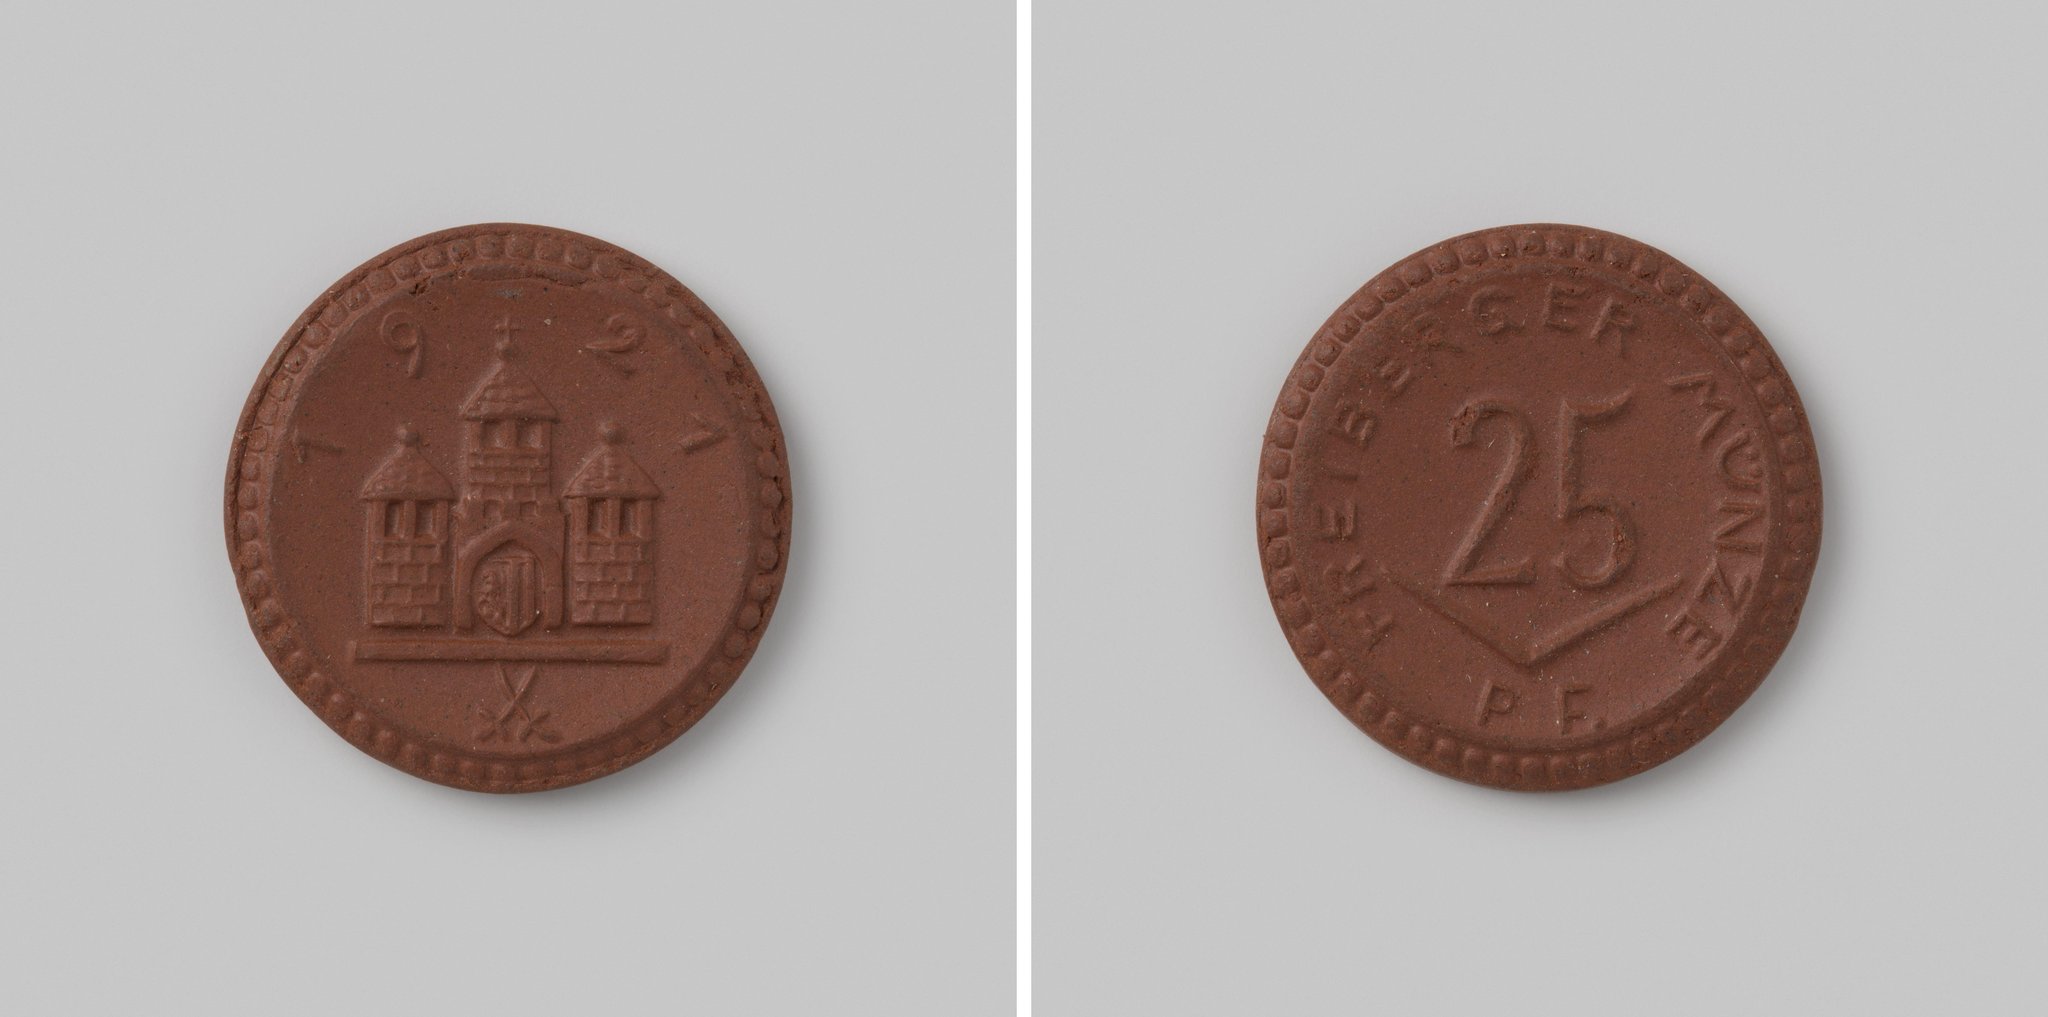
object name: coin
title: 25 pfennig uit Duitsland, Freiberg, 1921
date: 1921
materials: porcelain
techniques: casting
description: Porseleinen pseudomunt. Voorzijde: kerkgebouw, waarboven jaartal. Keerzijde: waarde-aanduiding in twee regels. Daarboven plaatsaanduiding. Gladde rand.